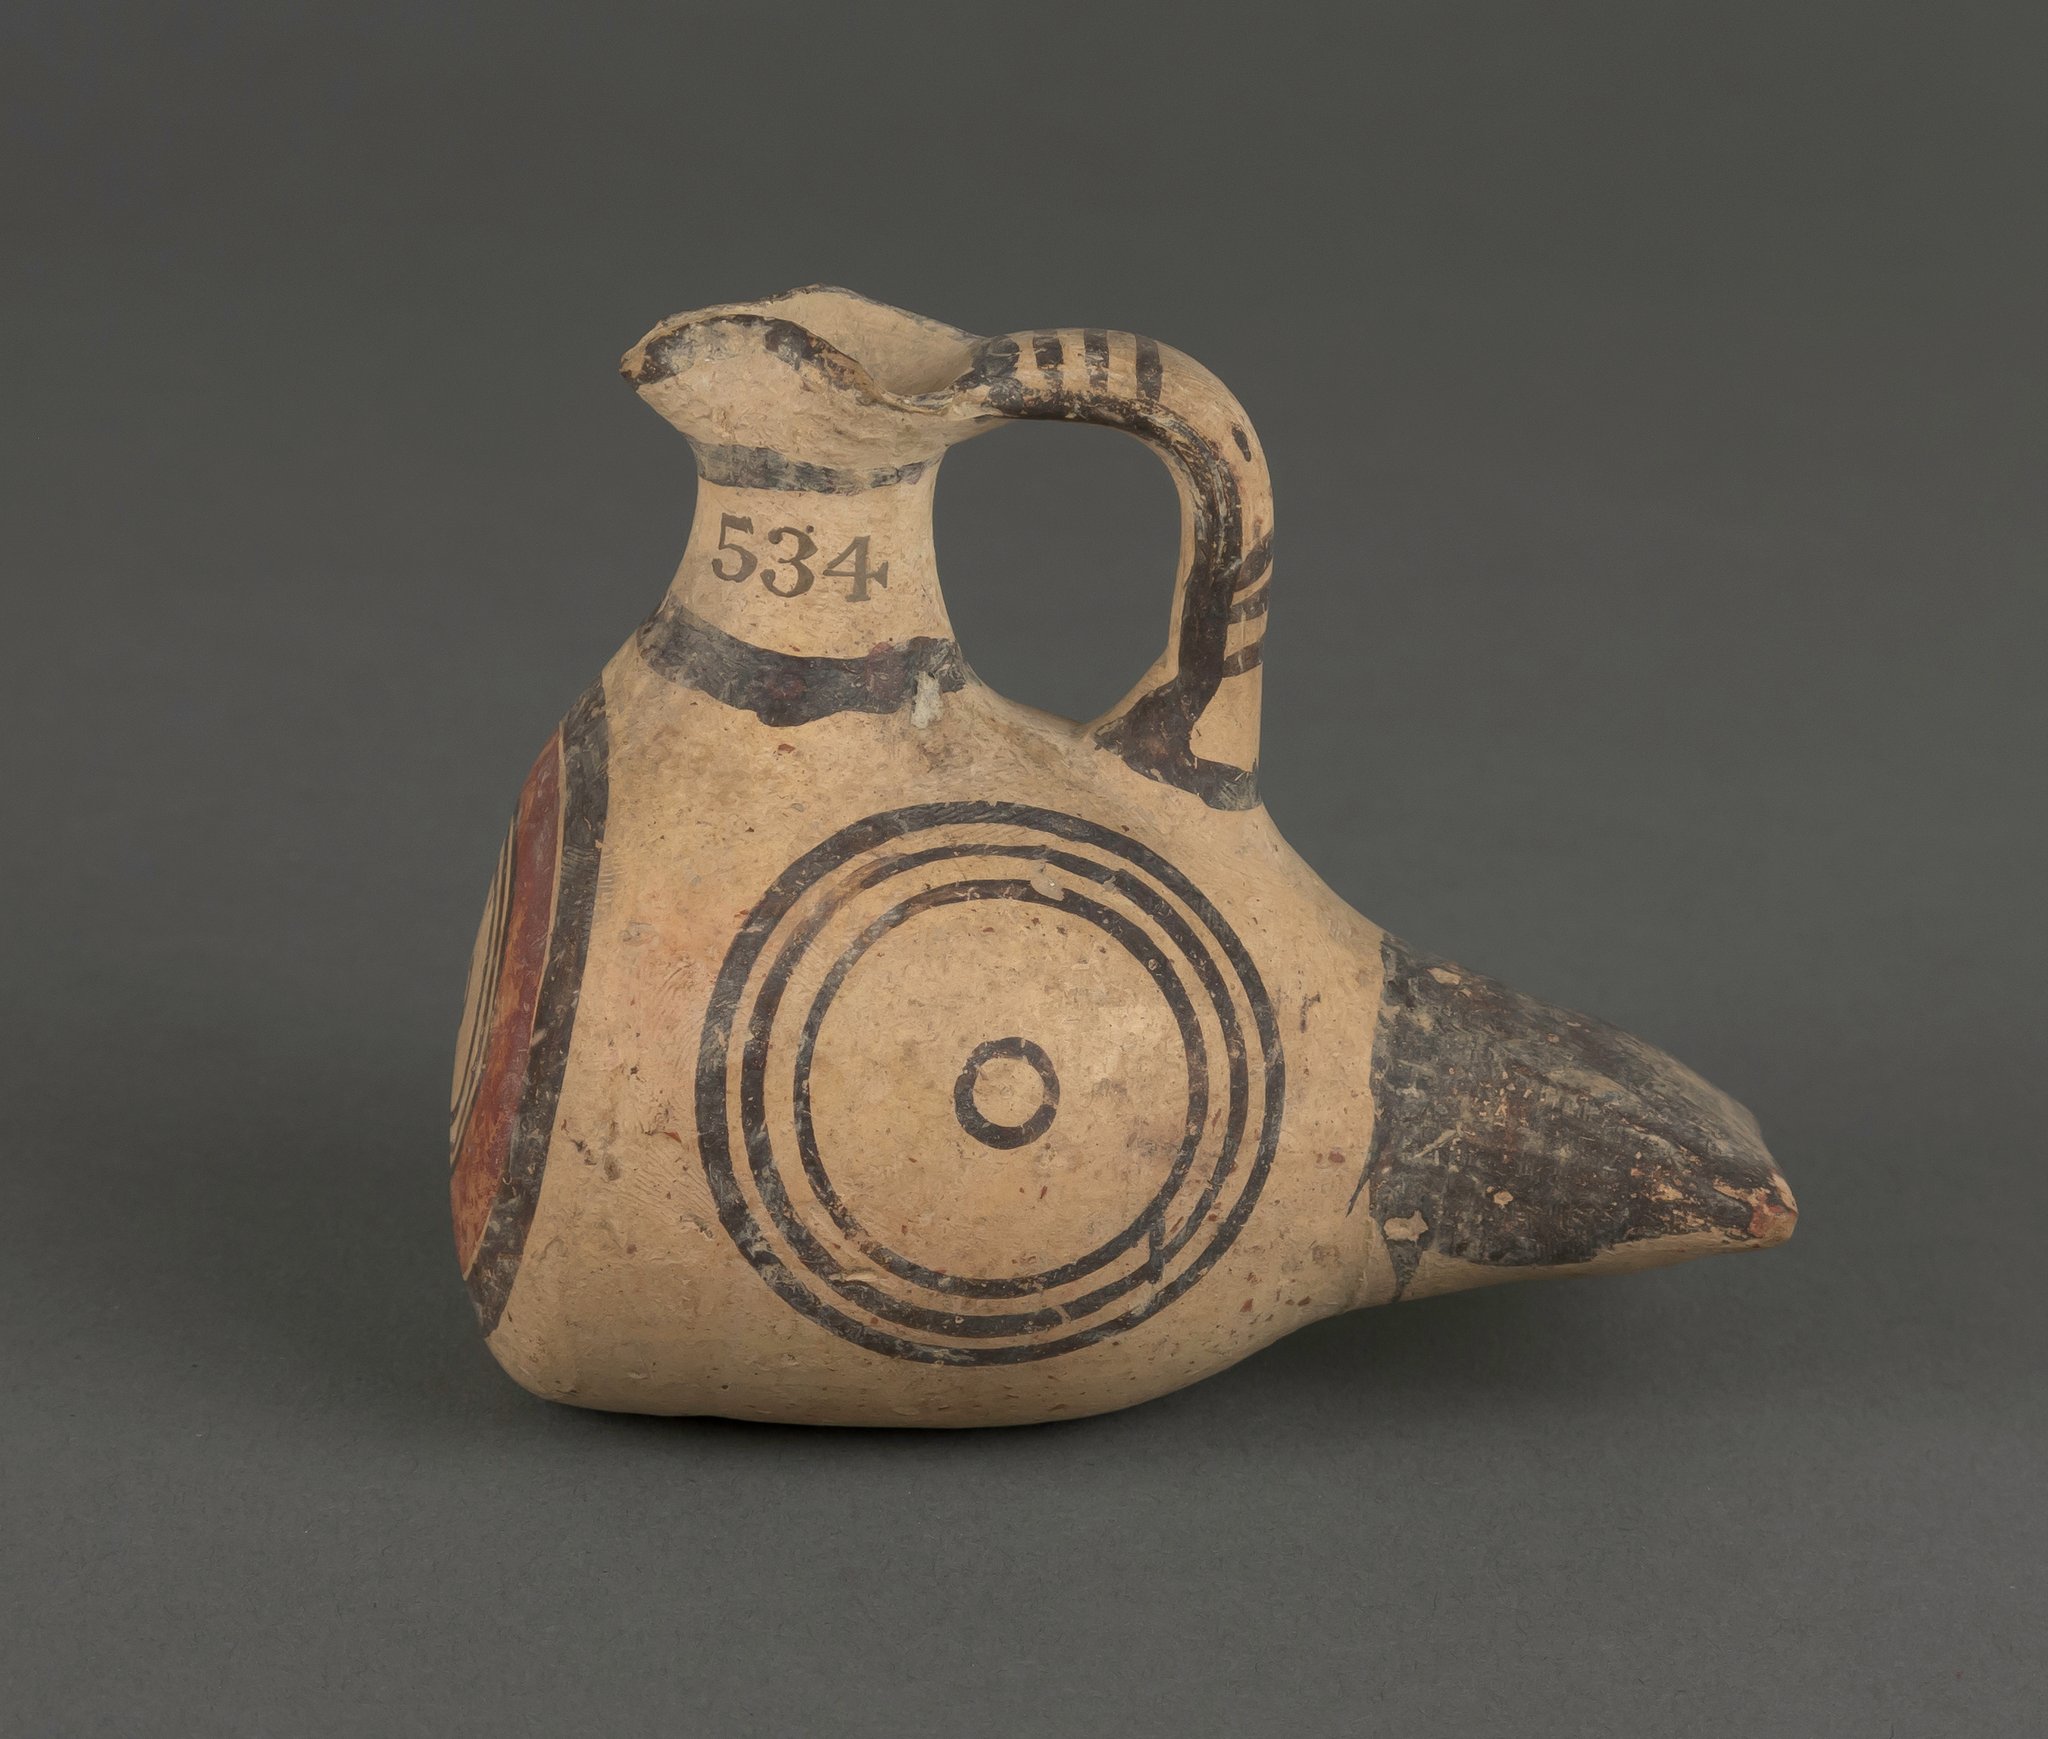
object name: askos in the form of a bird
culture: cypriot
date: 750-480 BCE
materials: terracotta